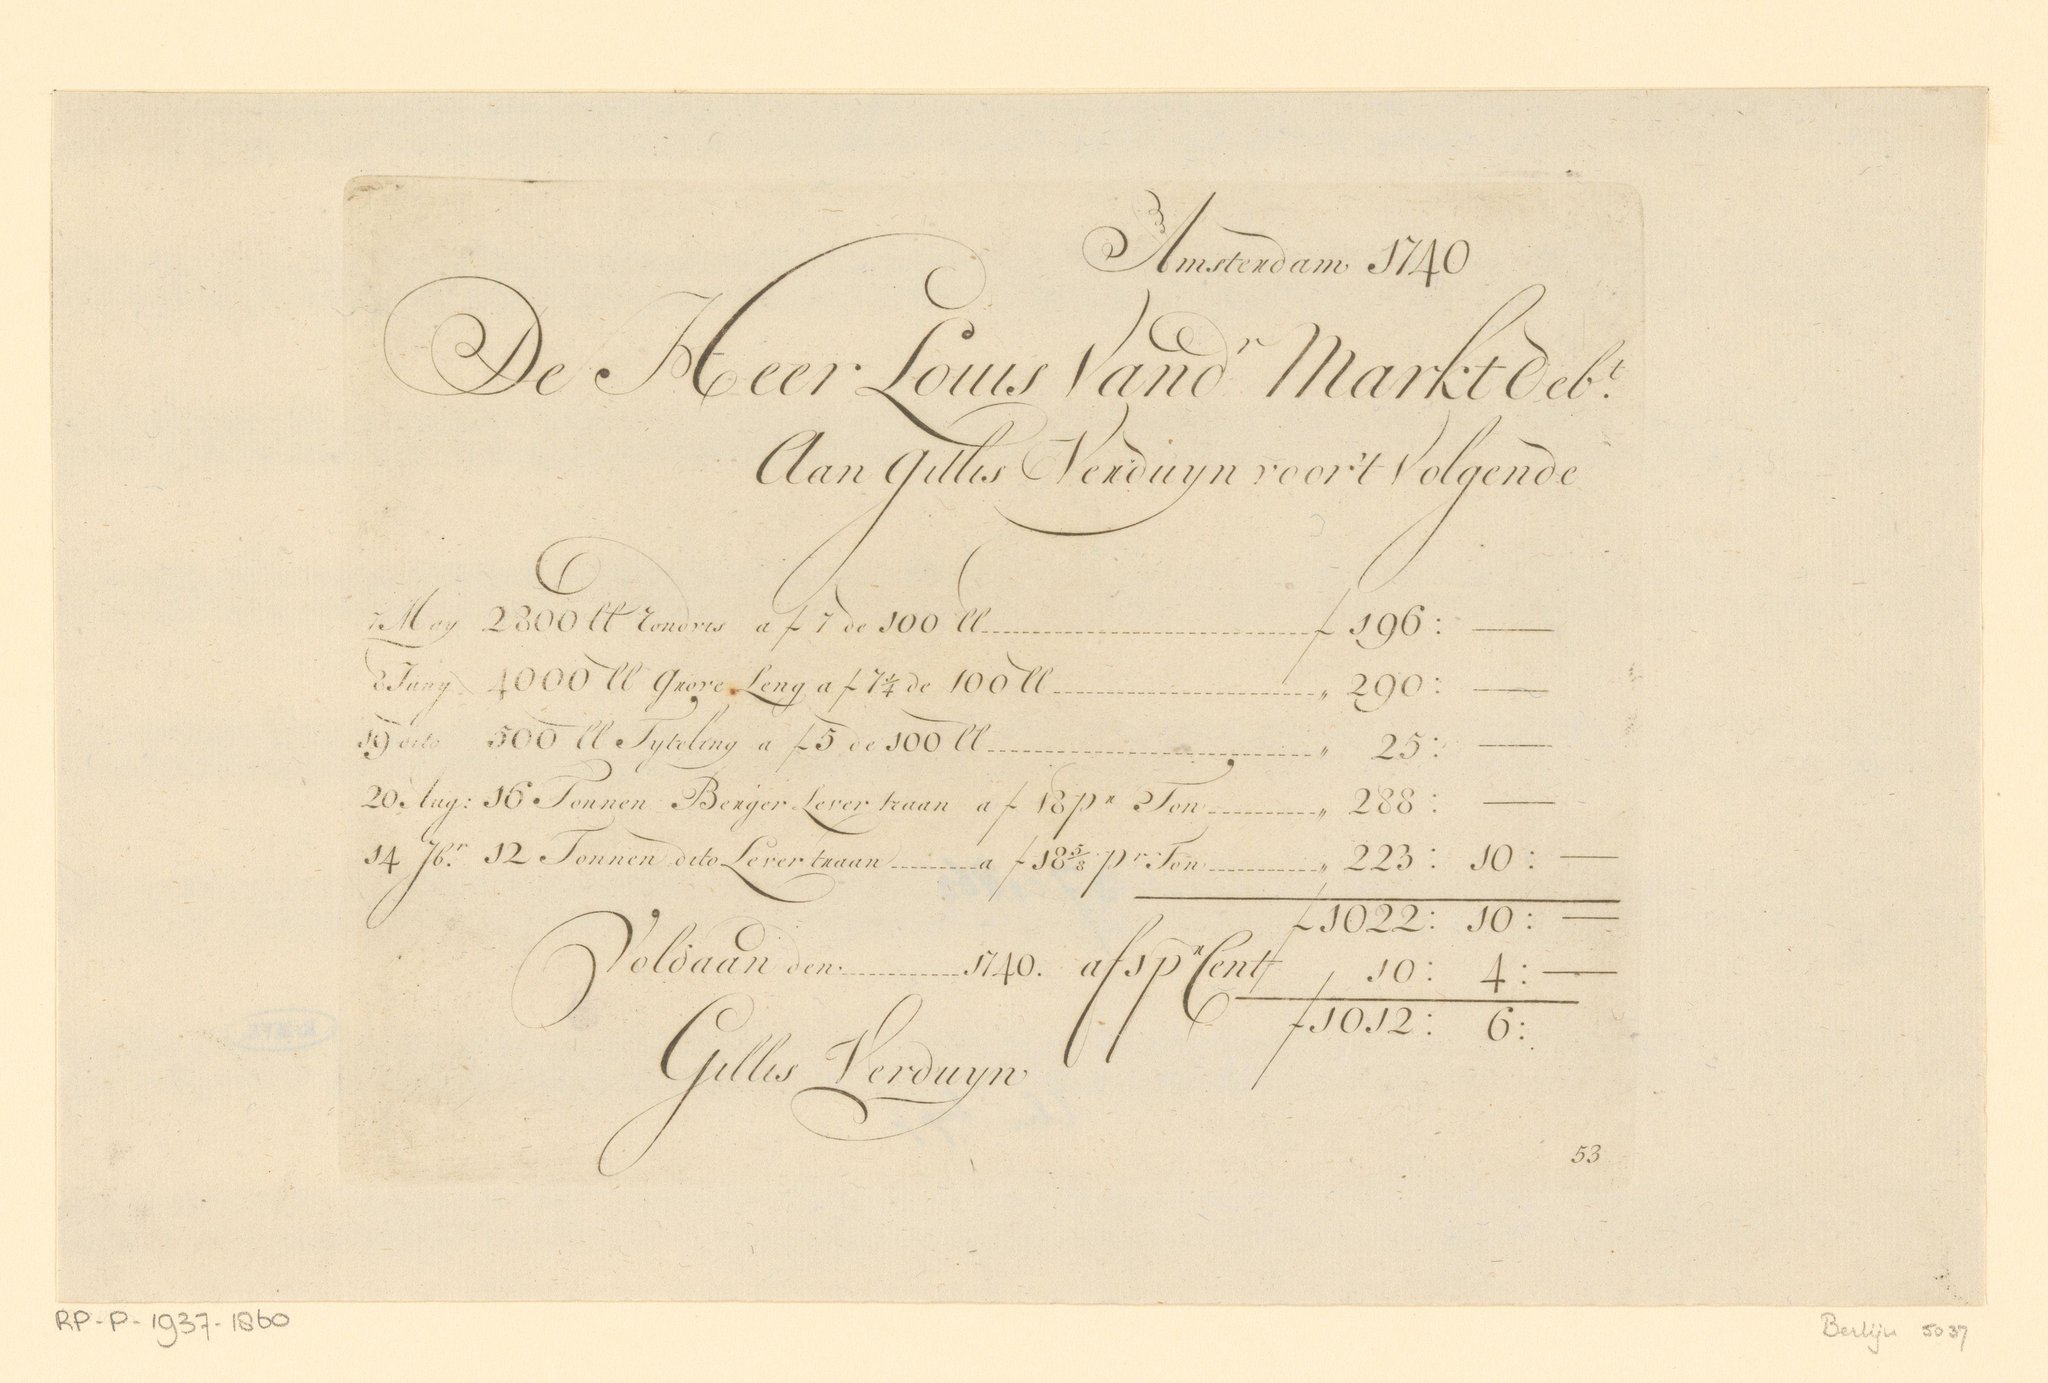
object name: print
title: Schrijfvoorbeeld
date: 1761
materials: paper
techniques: engraving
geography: amsterdam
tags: calligraphy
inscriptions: collector's mark: Lugt 2228, collector's mark: Lugt 2760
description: Gekalligrafeerde tekst: Amsterdam 1740 / De Heer Louis Vandr Markt (...)